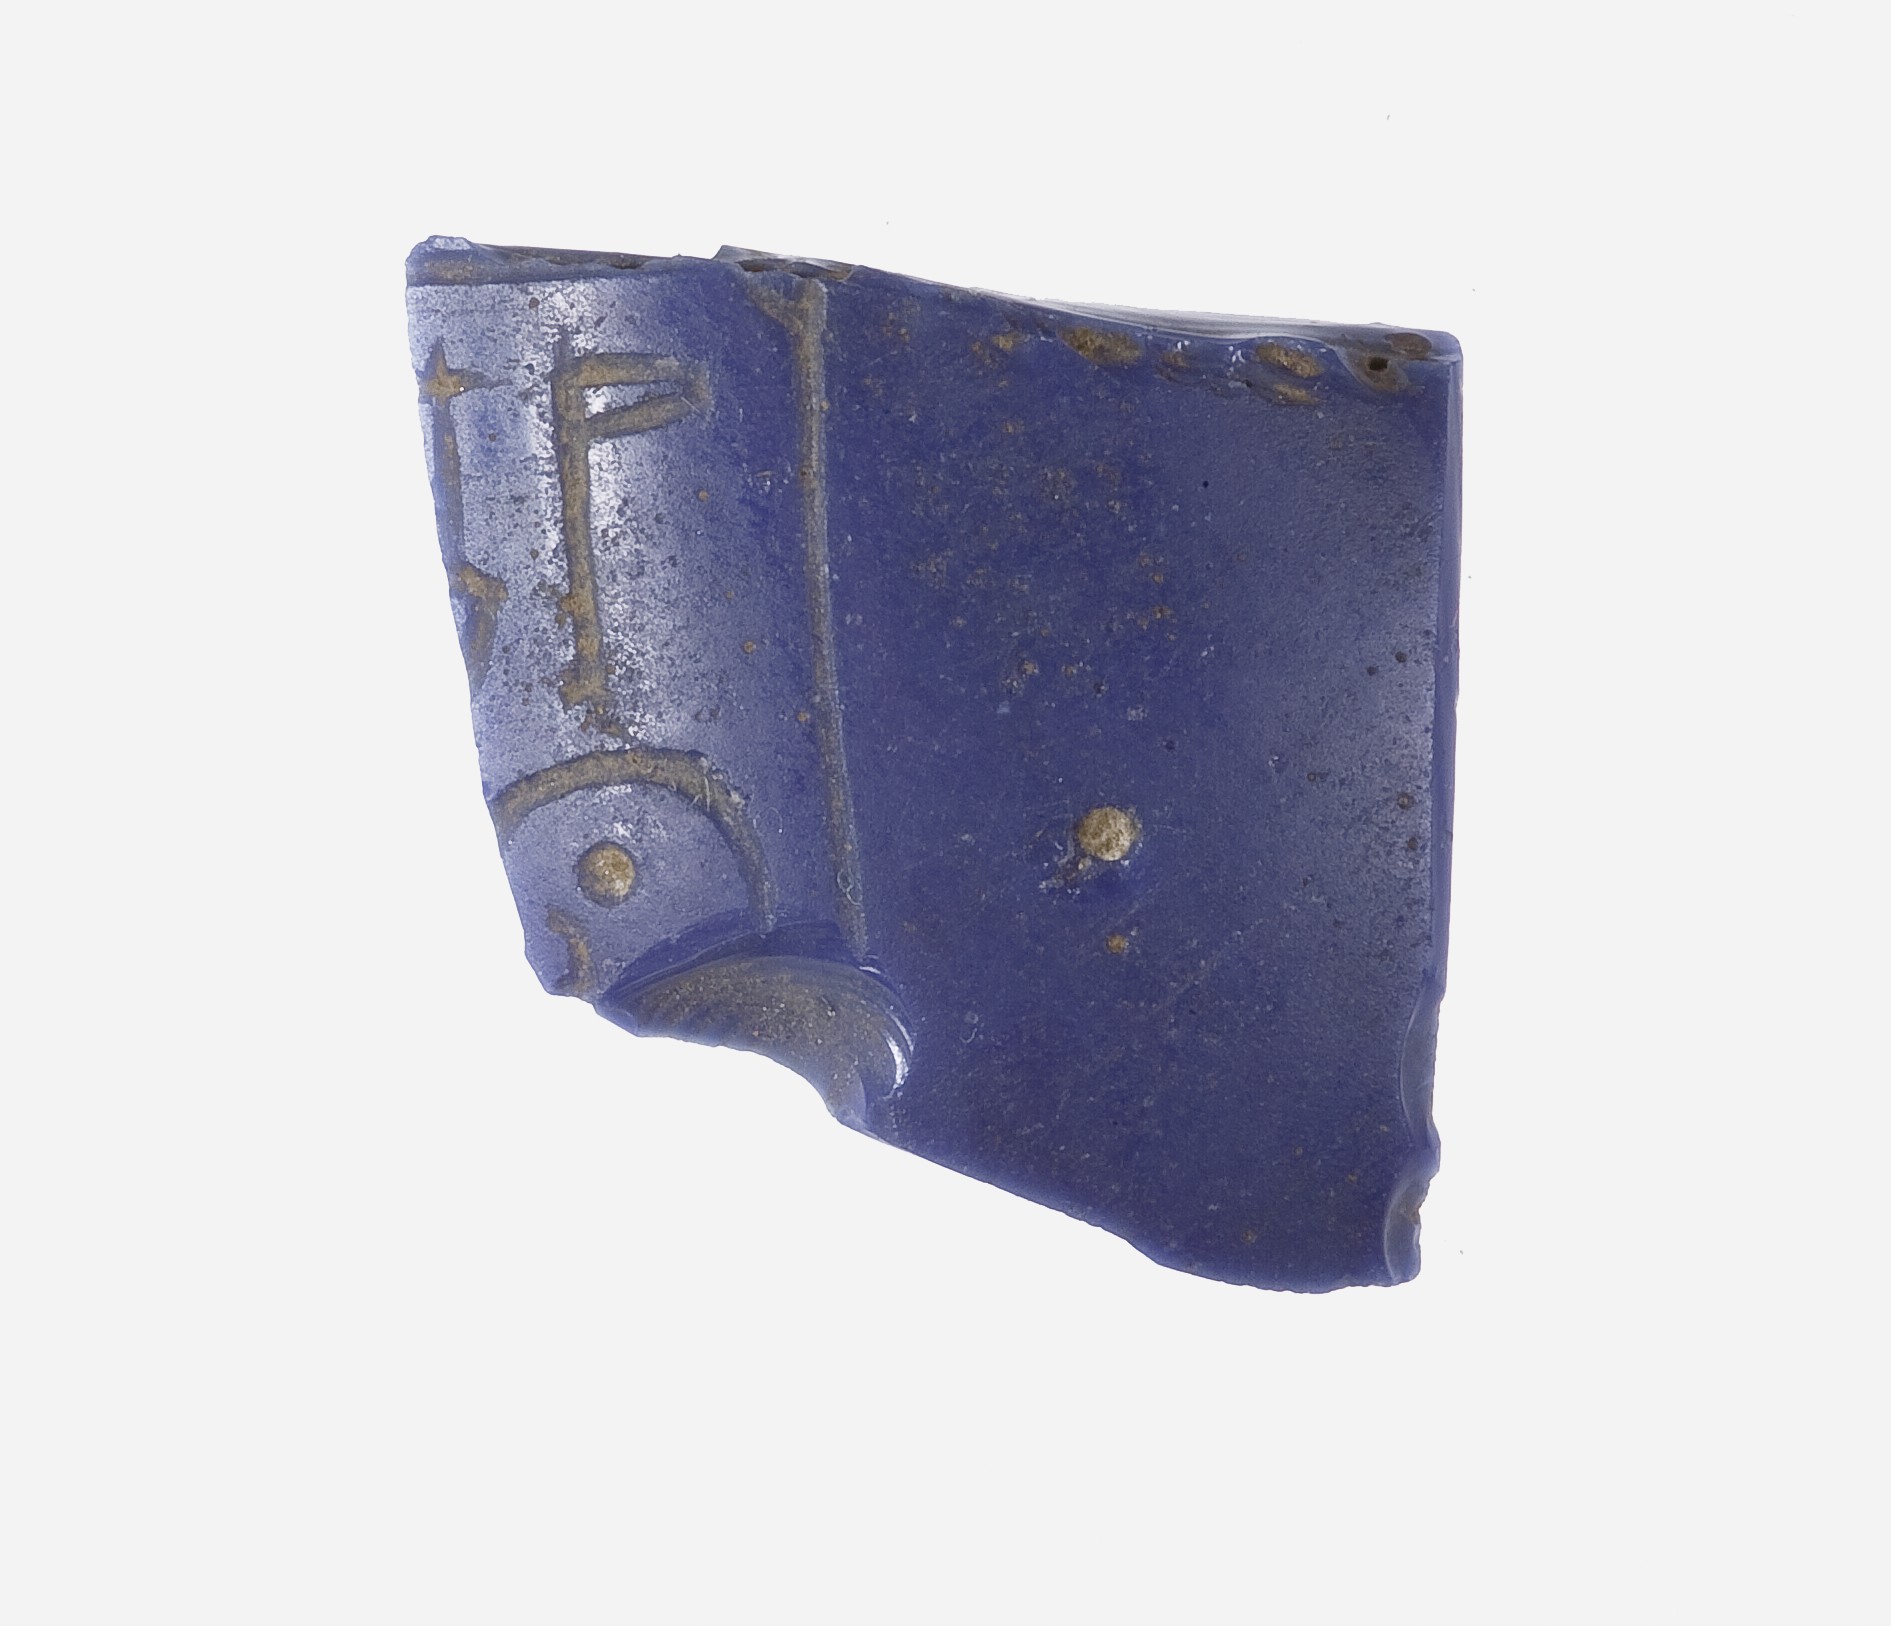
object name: vase fragment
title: Inscribed Fragment of Vase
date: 1390-1352 BCE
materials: glass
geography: egypt